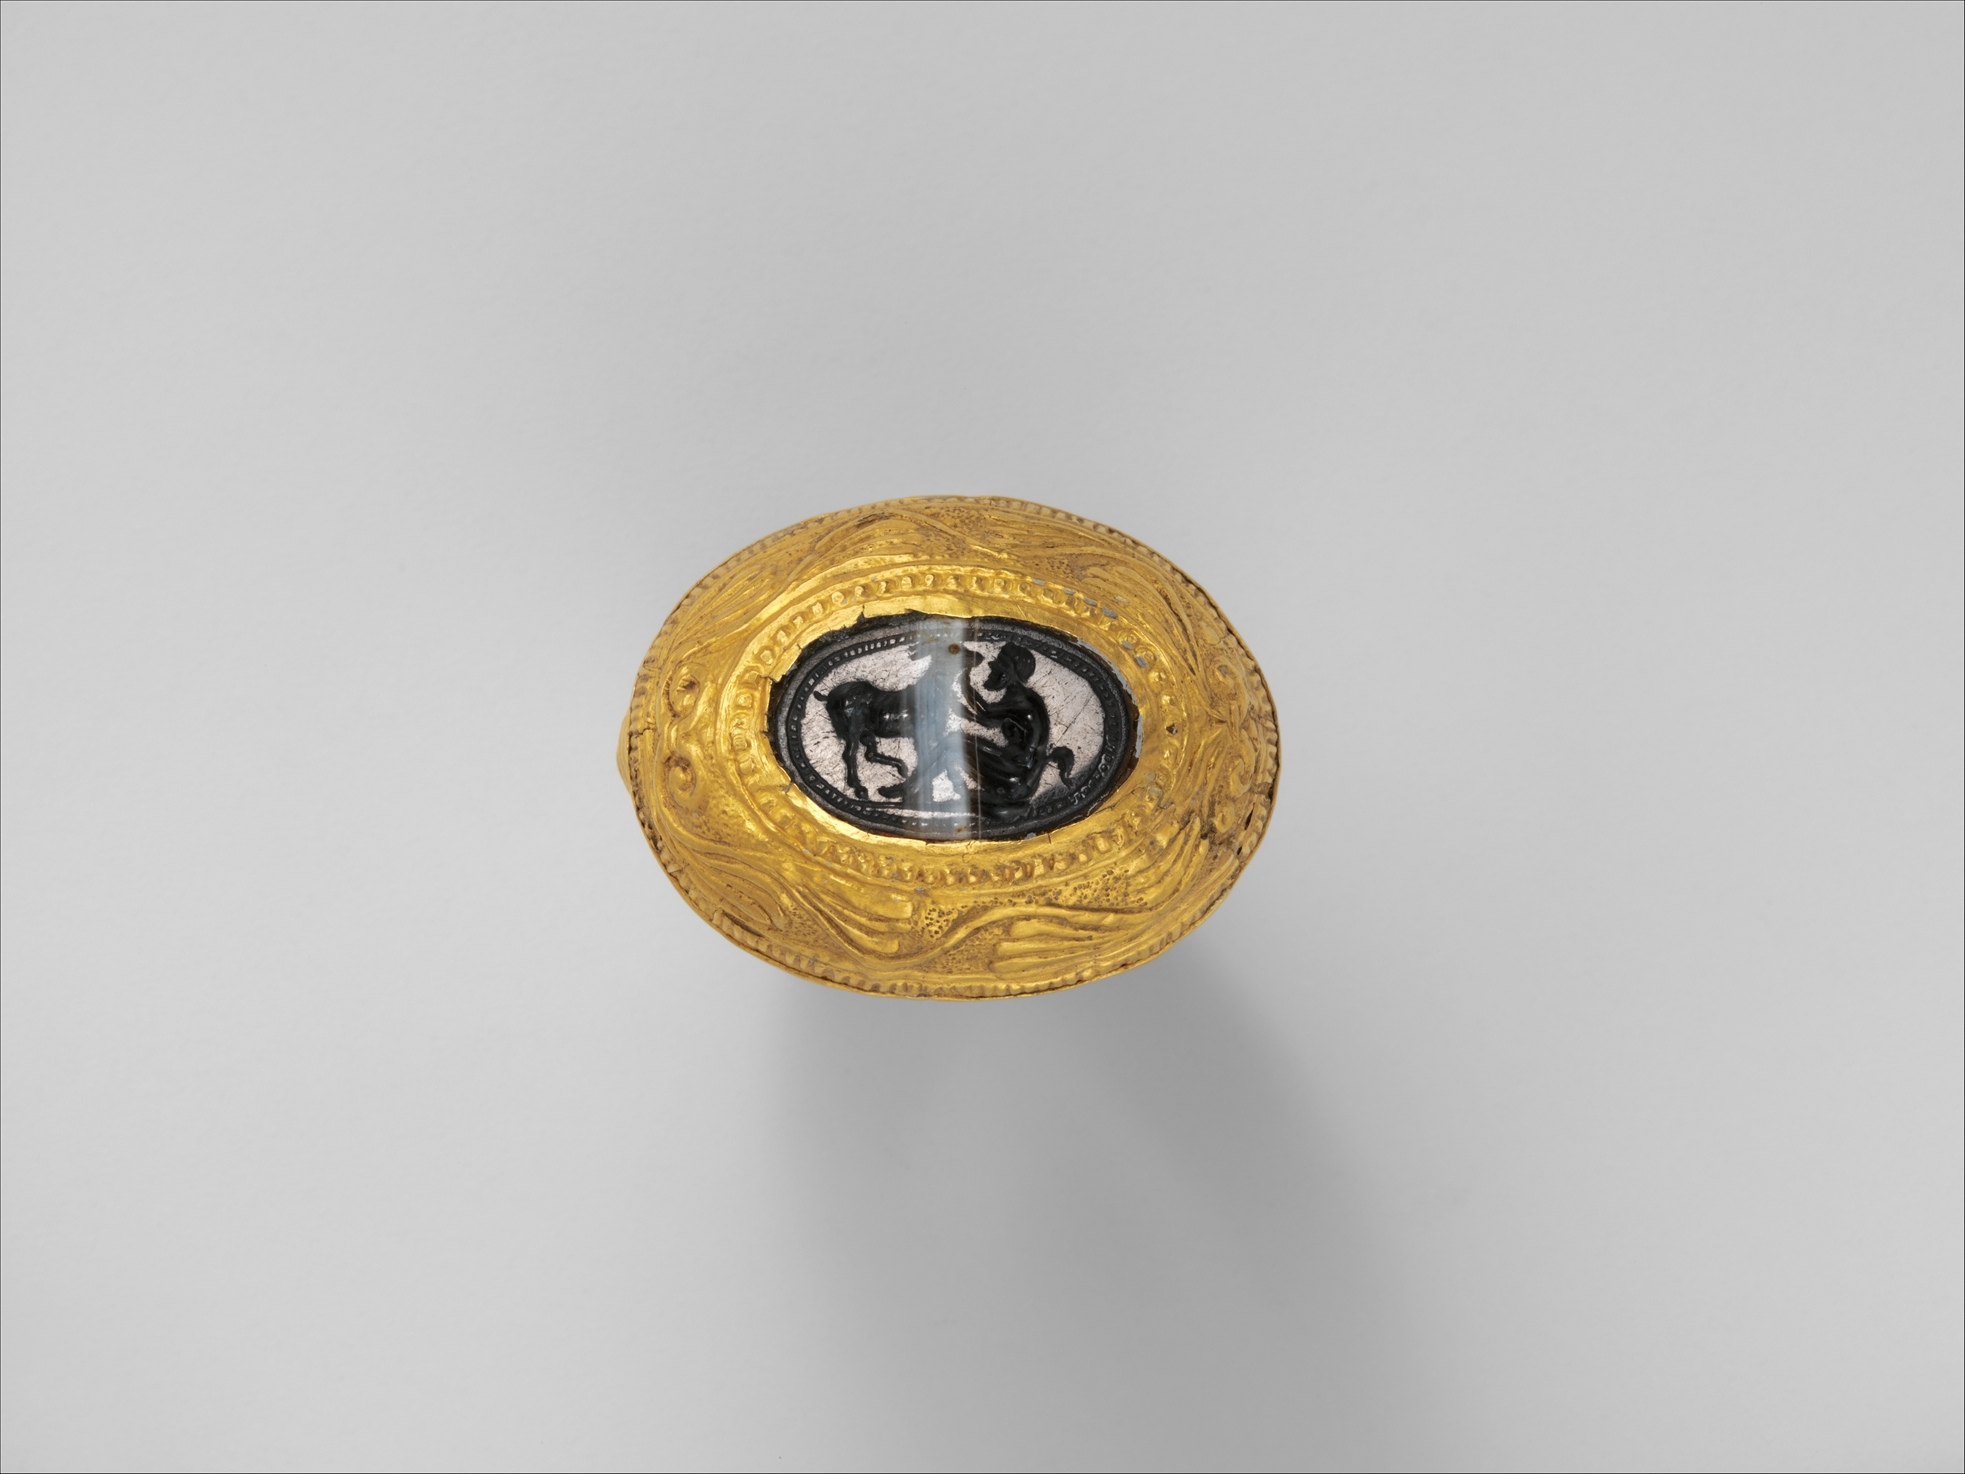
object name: intaglio in ring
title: Banded agate intaglio set in a large gold ring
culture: etruscan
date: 300-201 BCE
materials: stone, gold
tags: satyrs,goats